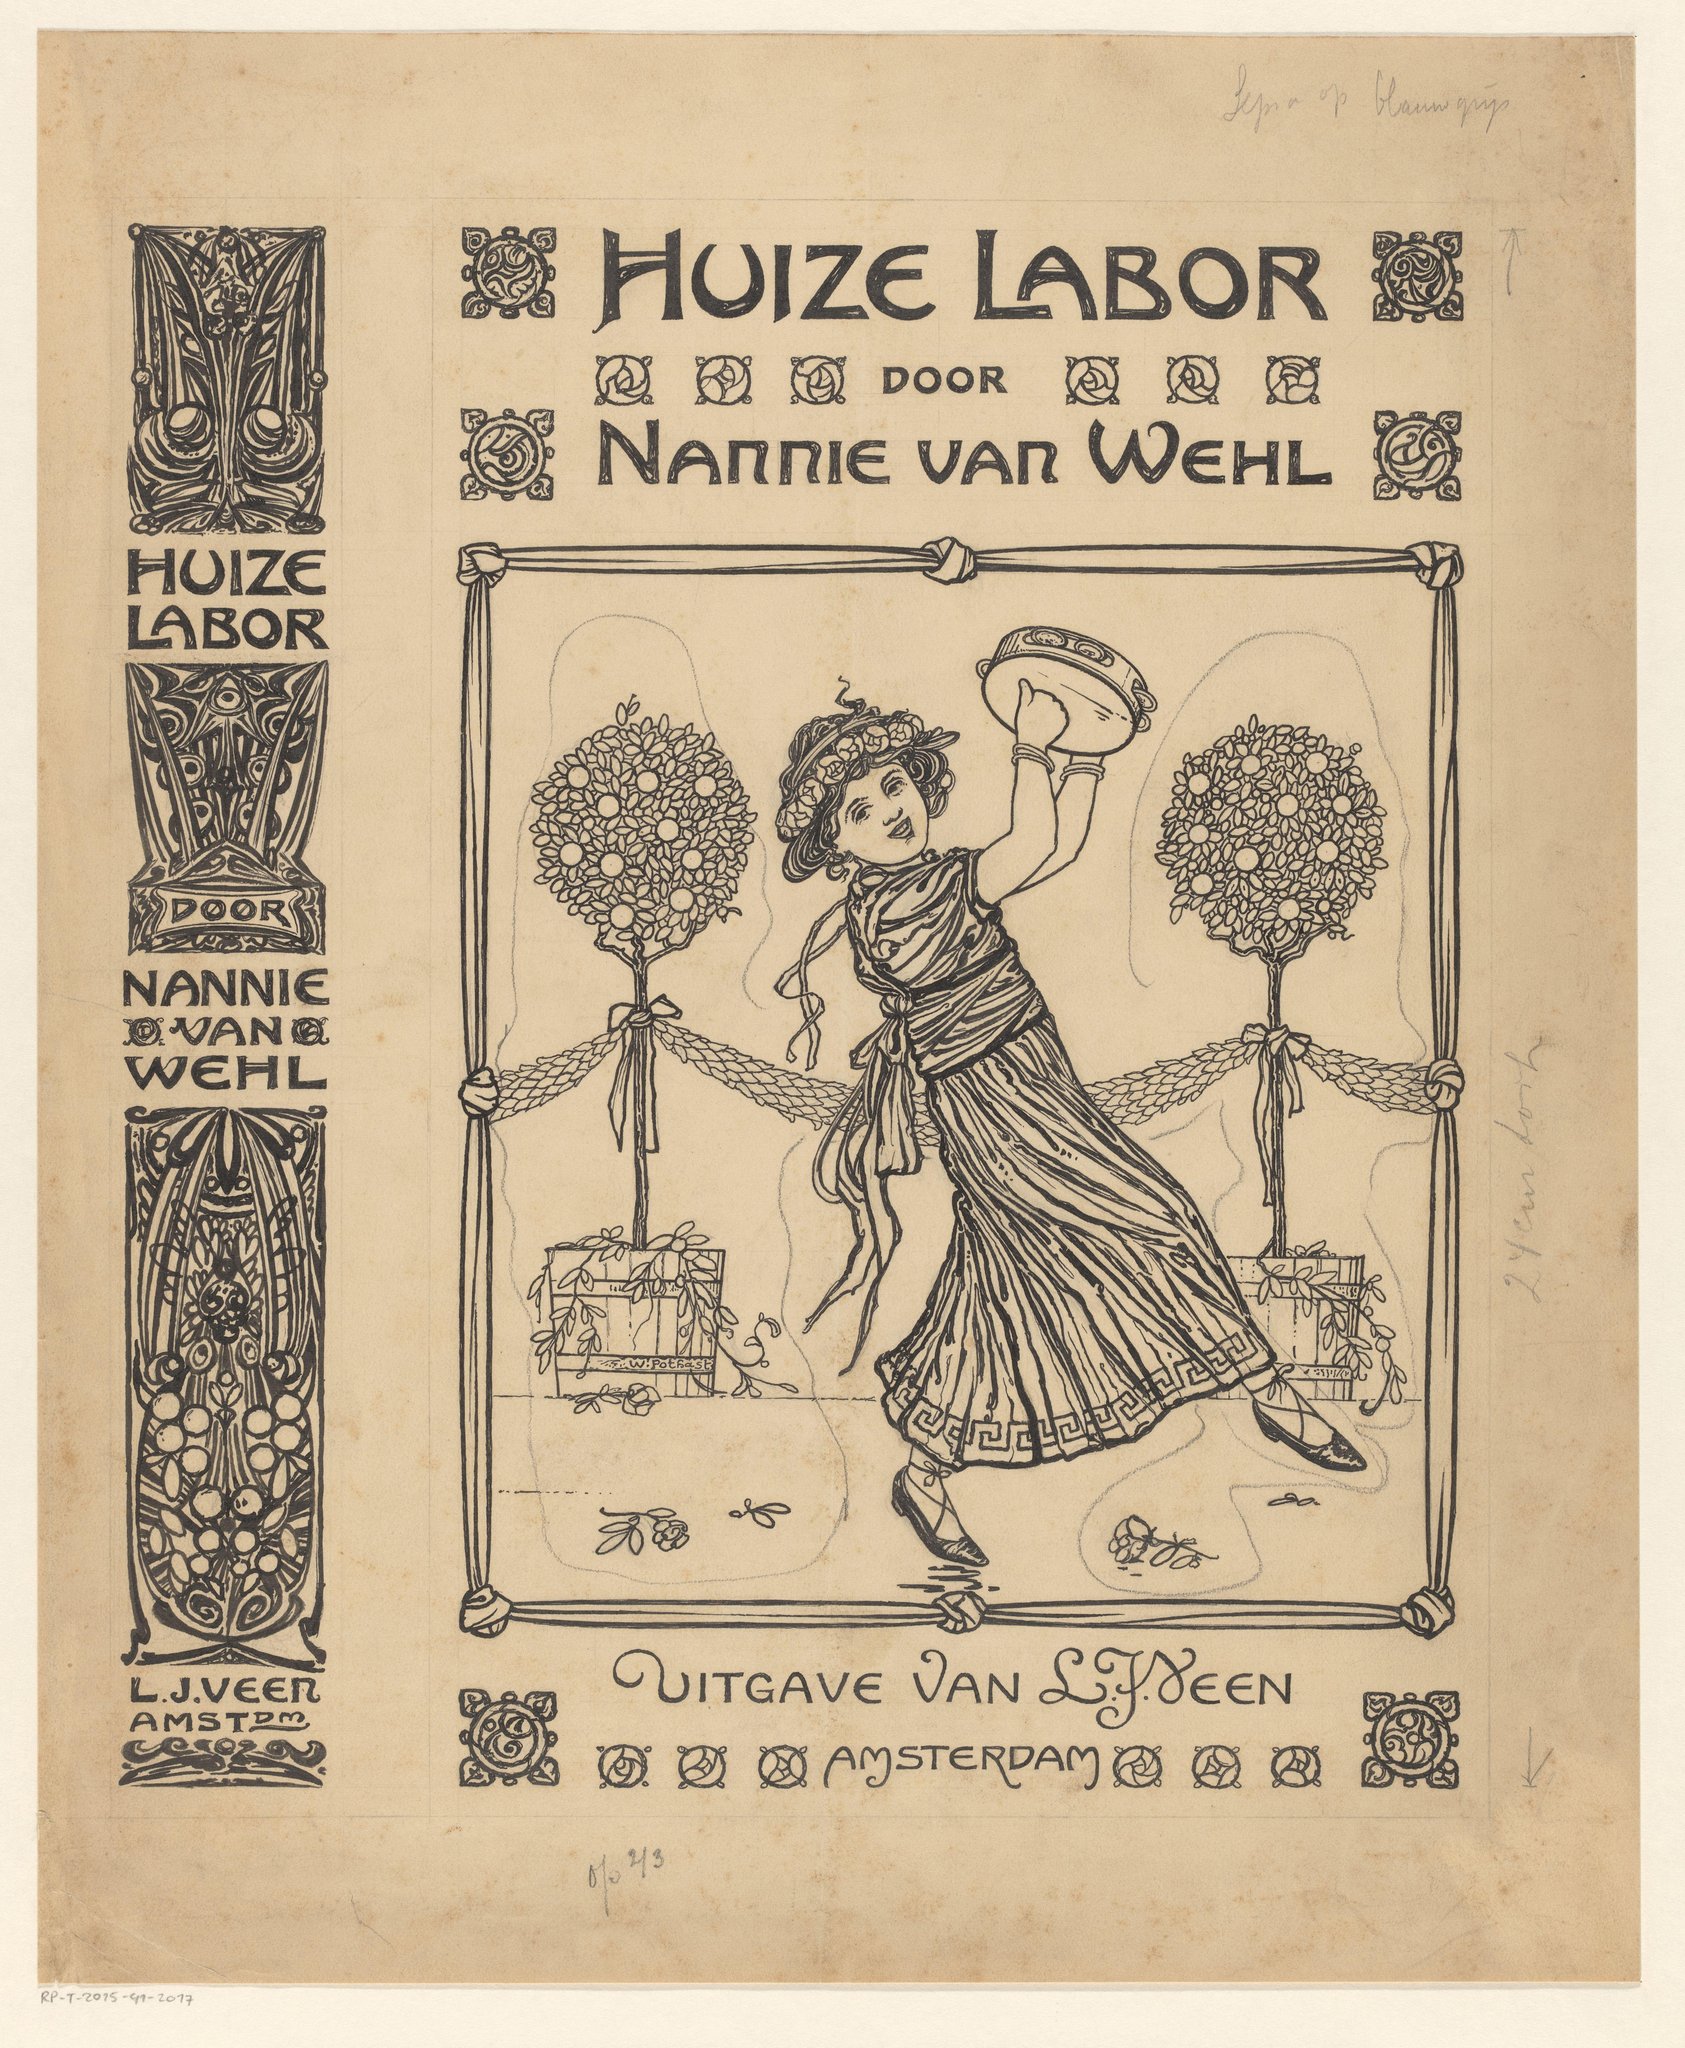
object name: study for binding design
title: Bandontwerp voor: Nannie van Wehl, Huize Labor, 1910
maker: willem pothast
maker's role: draughtsman, print maker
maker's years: 1877-1916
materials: ink, paper, pencil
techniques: brush, pen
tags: fruit-tree culture; fruit harvest, tambourine - cc - out of doors, girl (child between toddler and youth)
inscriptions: signature: ‘W.Pothast’, :, collector's mark: Lugt 2228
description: Een lachend meisje huppelt over een pad en houdt een tamboerijn boven haar hoofd. Ze draagt een lange jurk en heeft een rozenkrans in haar opgestoken haar. In de achtergrond staan twee fruitbomen in houten potten. Op de boekrug ornamentele versieringen.